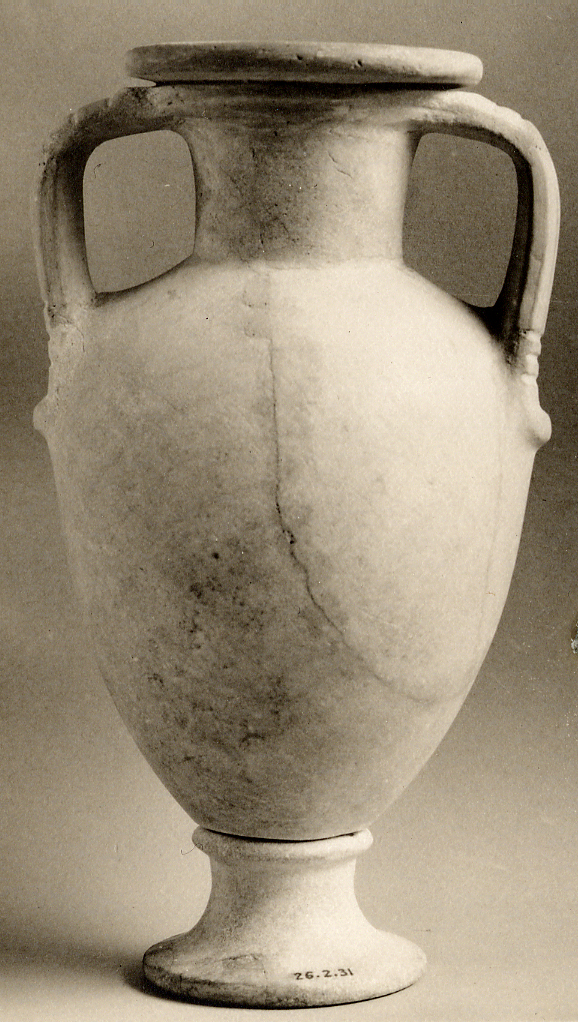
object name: jar, amphora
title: Amphora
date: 1550-1295 BCE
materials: limestone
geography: egypt